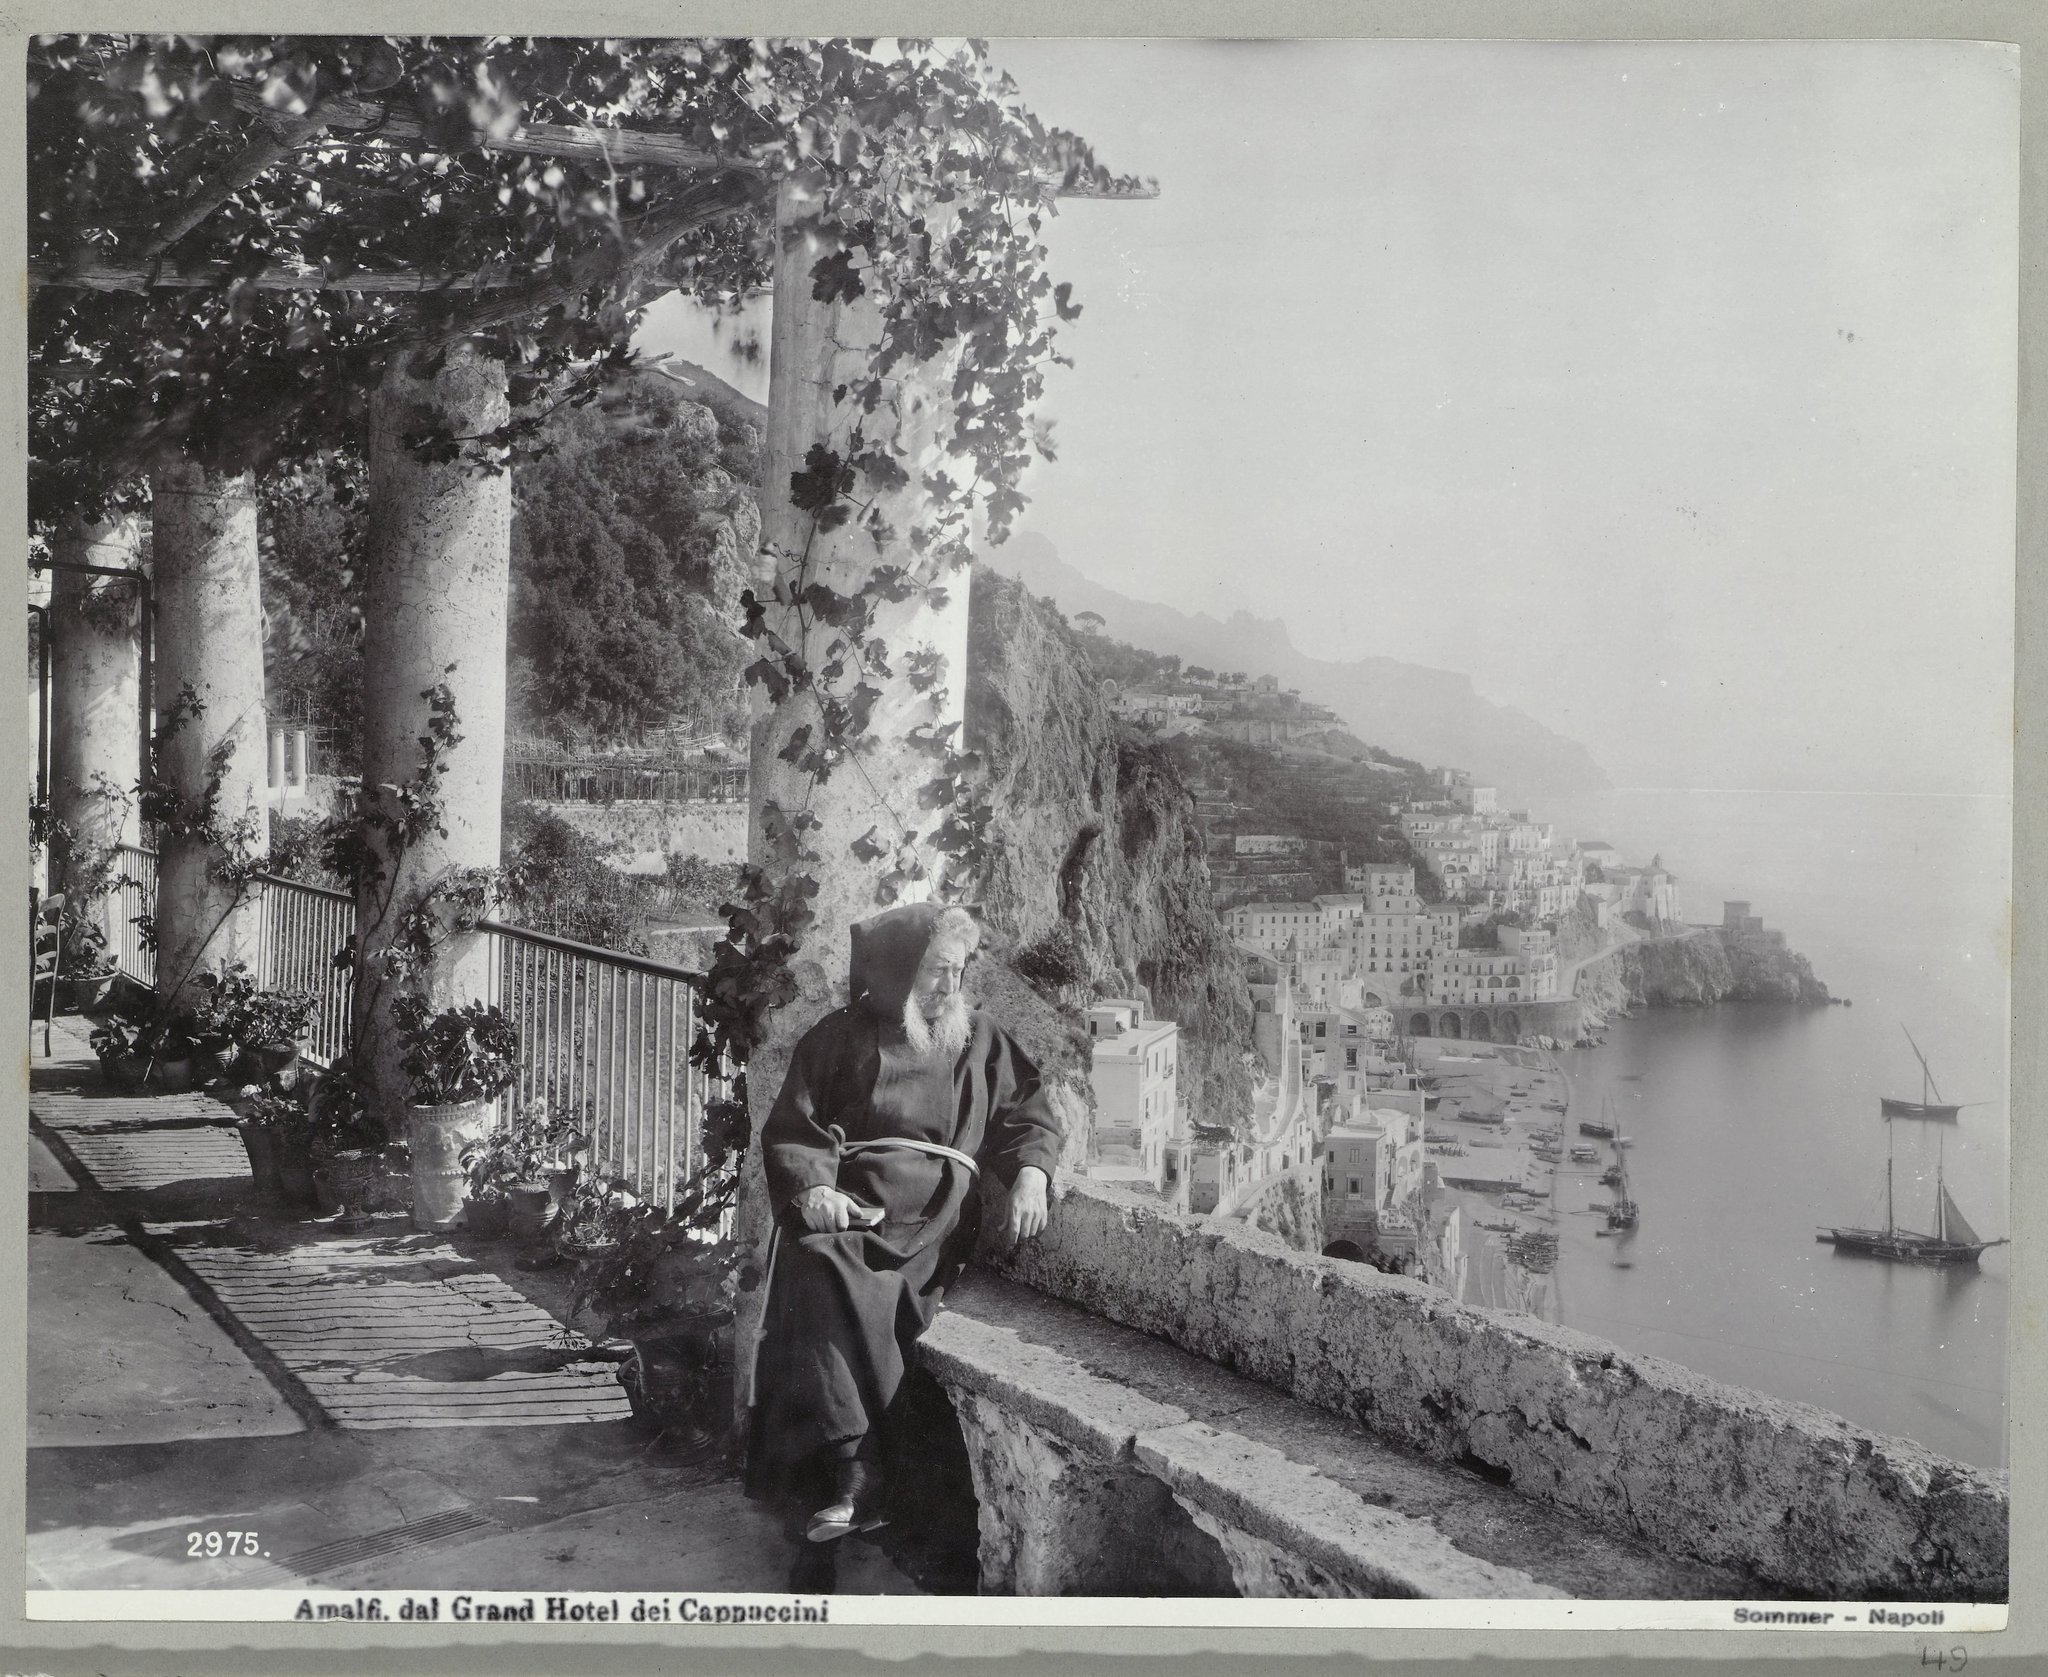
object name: photograph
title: Amalfi dal Grand Hotel dei Cappuccini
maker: giorgio sommer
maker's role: fotograaf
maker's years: 1834-1914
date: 1888-1903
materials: cardboard, photographic support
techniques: albumen print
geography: naples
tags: amalfi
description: Een Cappucijner monnik op een veranda uitkijkend over de stad Amalfi